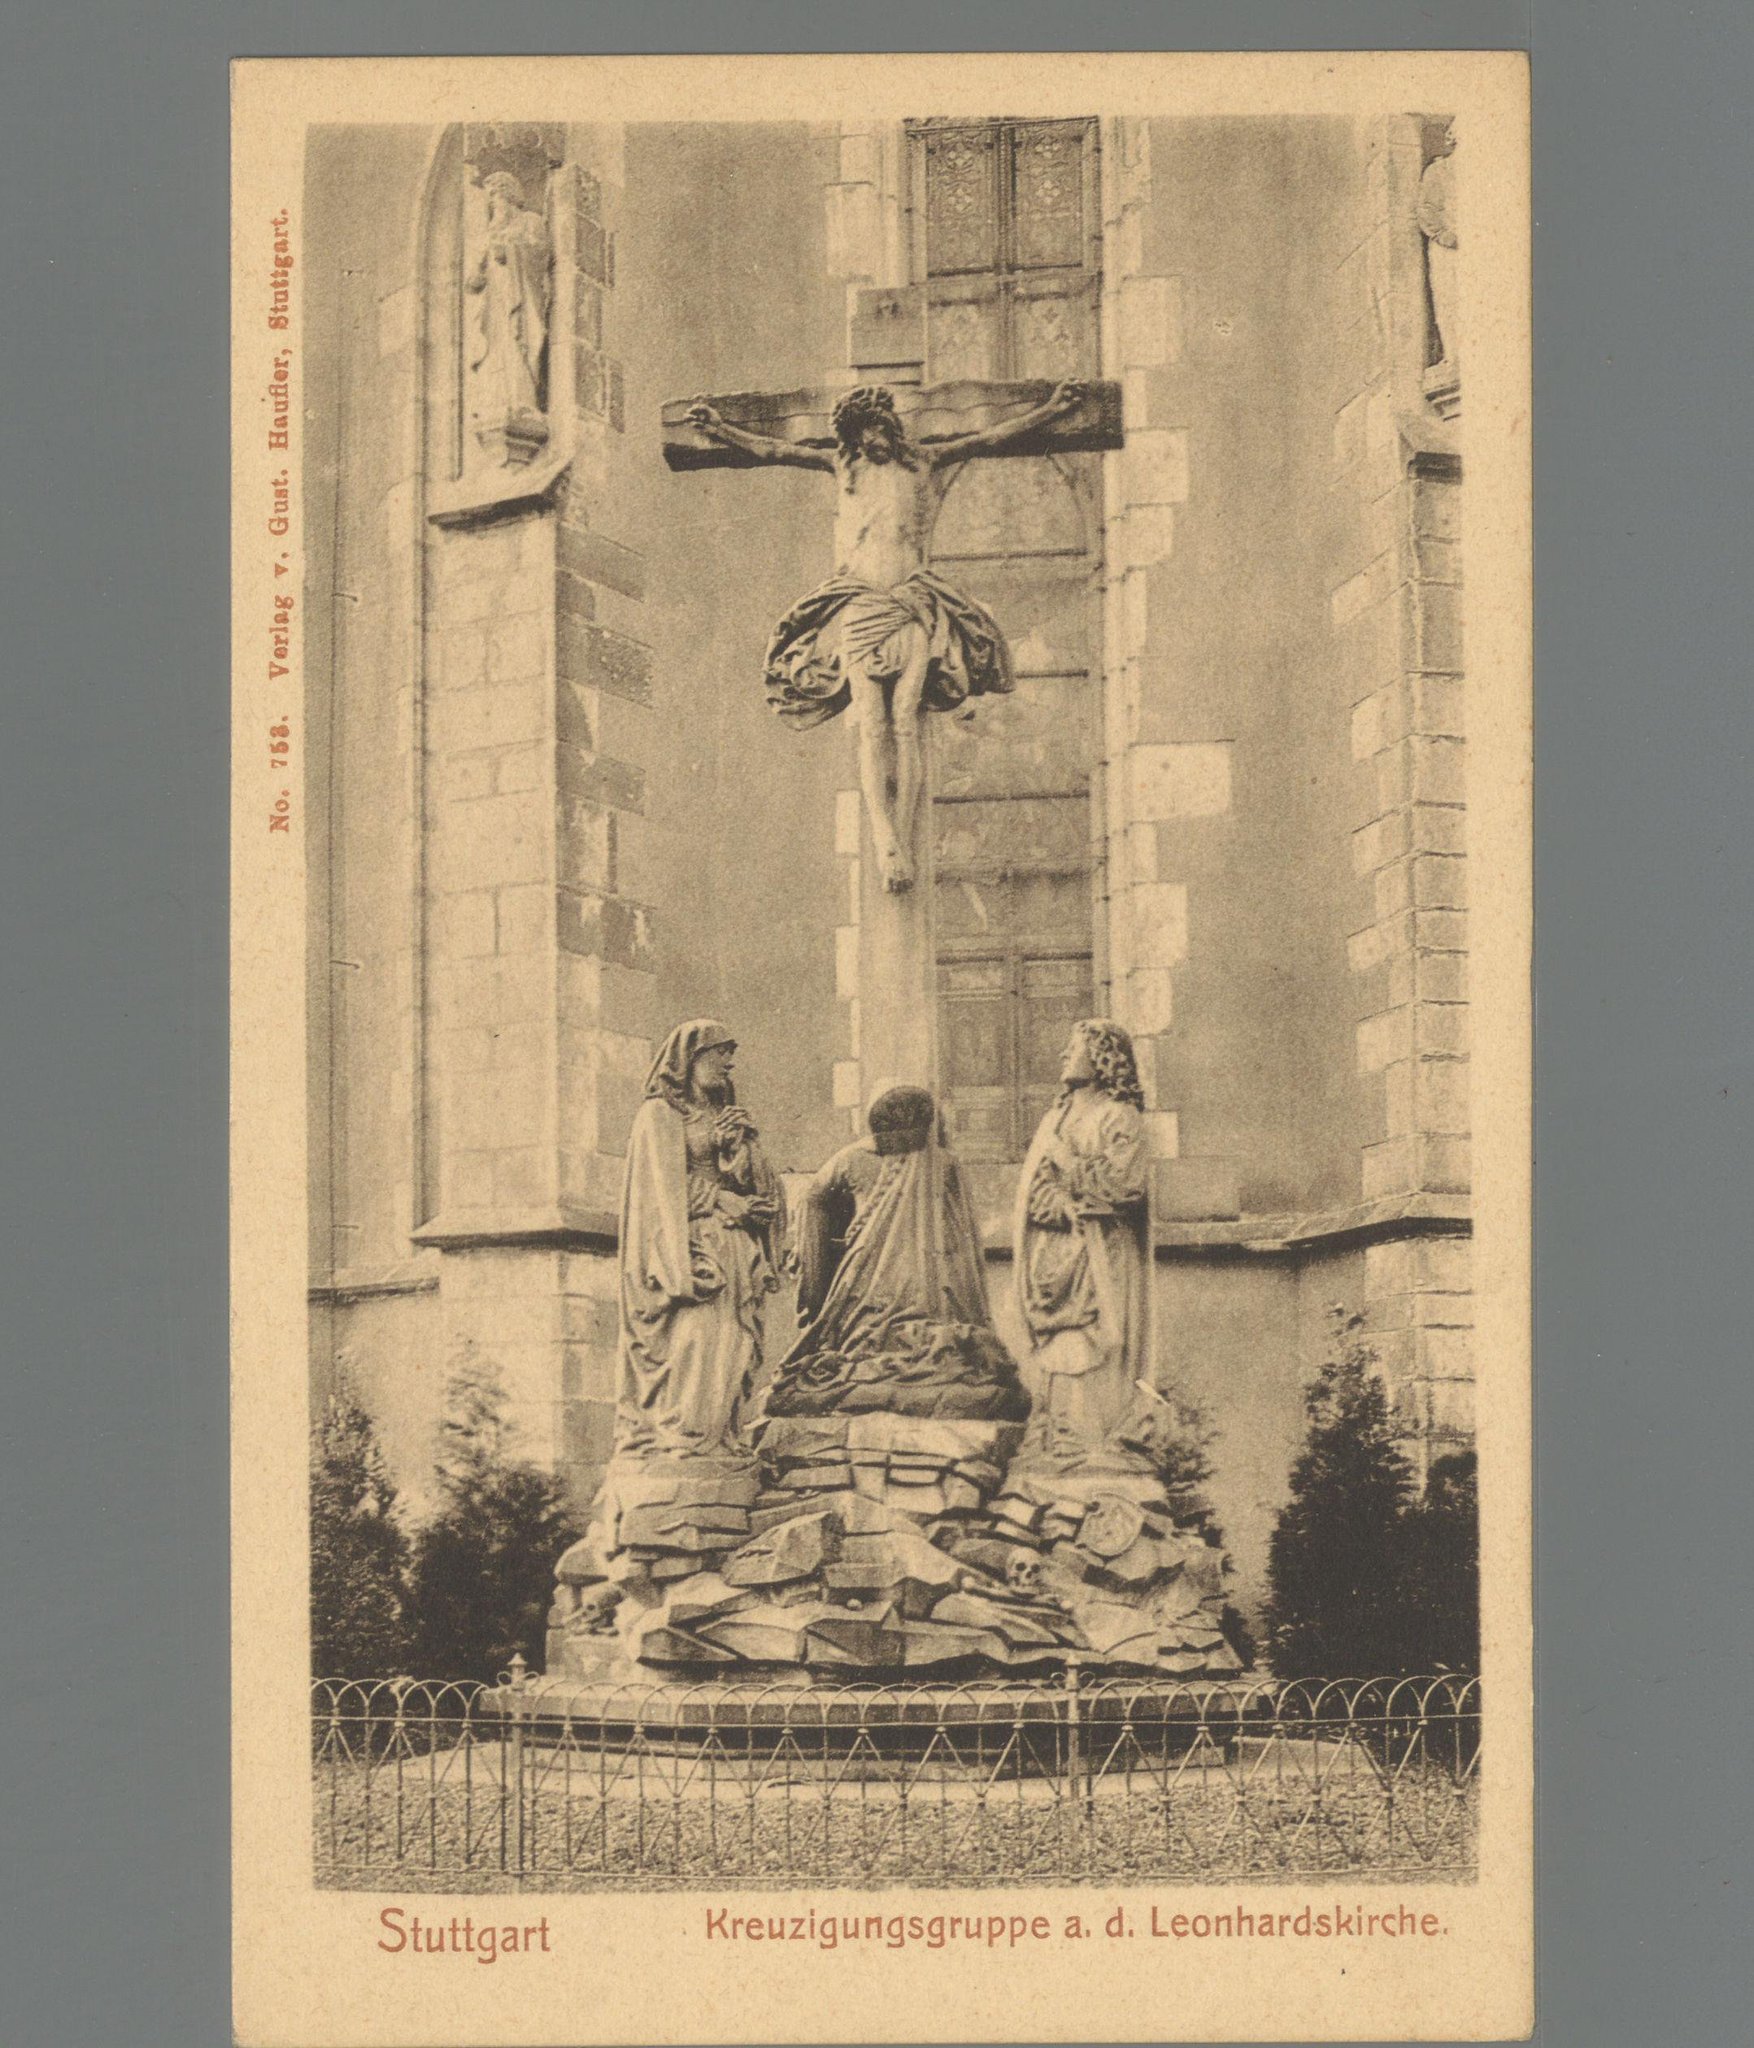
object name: ansichtkaart, prentbriefkaart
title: Stuttgart. Kreuzigungsgruppe a.d. Leonhardskirche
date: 1905-1930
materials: cardboard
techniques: photograph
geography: stuttgart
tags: altarcross, crucifix, church (exterior)